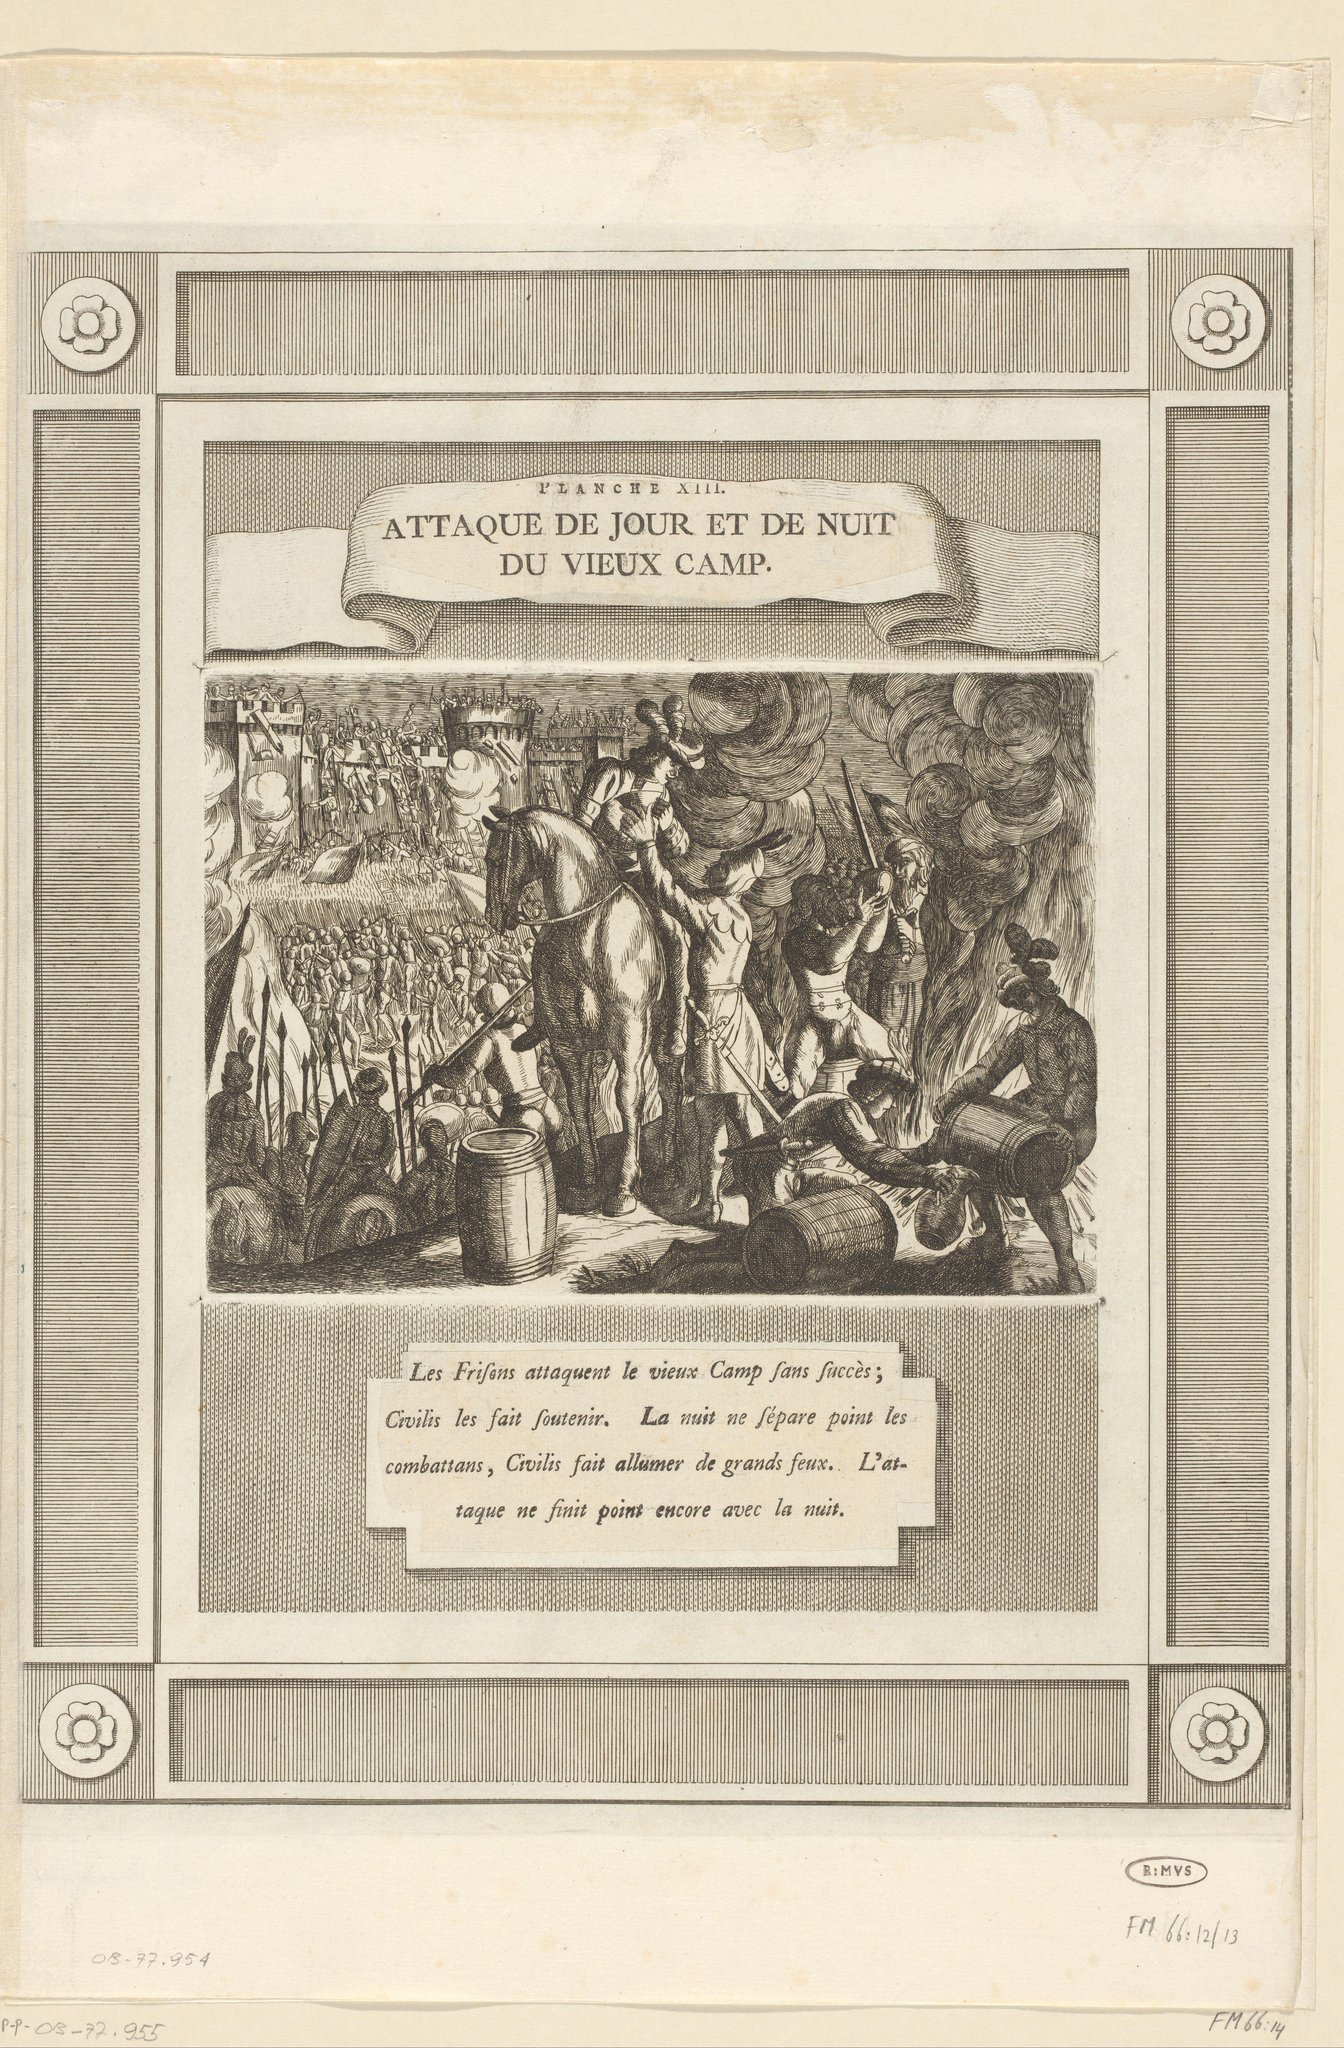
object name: print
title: Kopieën naar Tempesta's Bataafse Opstand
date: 1768-1770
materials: paper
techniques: engraving, etching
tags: battle, fighting in general, extinct, 'historical' peoples (with name), netherlands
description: Nachtelijke aanval op een Romeinse vesting. De soldaten bedrinken zich in het legerkamp. Prent 13 in een serie over de Bataafse Opstand, gekopieerd naar de reeks Batavorum cum Romanis bellum van Antonio Tempesta (Otto Vaenius, Antwerpen 1612). Illustratie voor: Marquis de St. Simon, Histoire de la guerre des Bataves et des Romains, d'après César; Corneille Tacite, Aux dépens de Marc-Michel Rey, Amsterdam 1770. Voorstellingen gedrukt in een grote ornamentele omlijsting waarin bovenaan een uitgeknipte titel en onderaan een onderschrift in het Frans is geplakt. Gedrukt op de achterkant van planche XII.